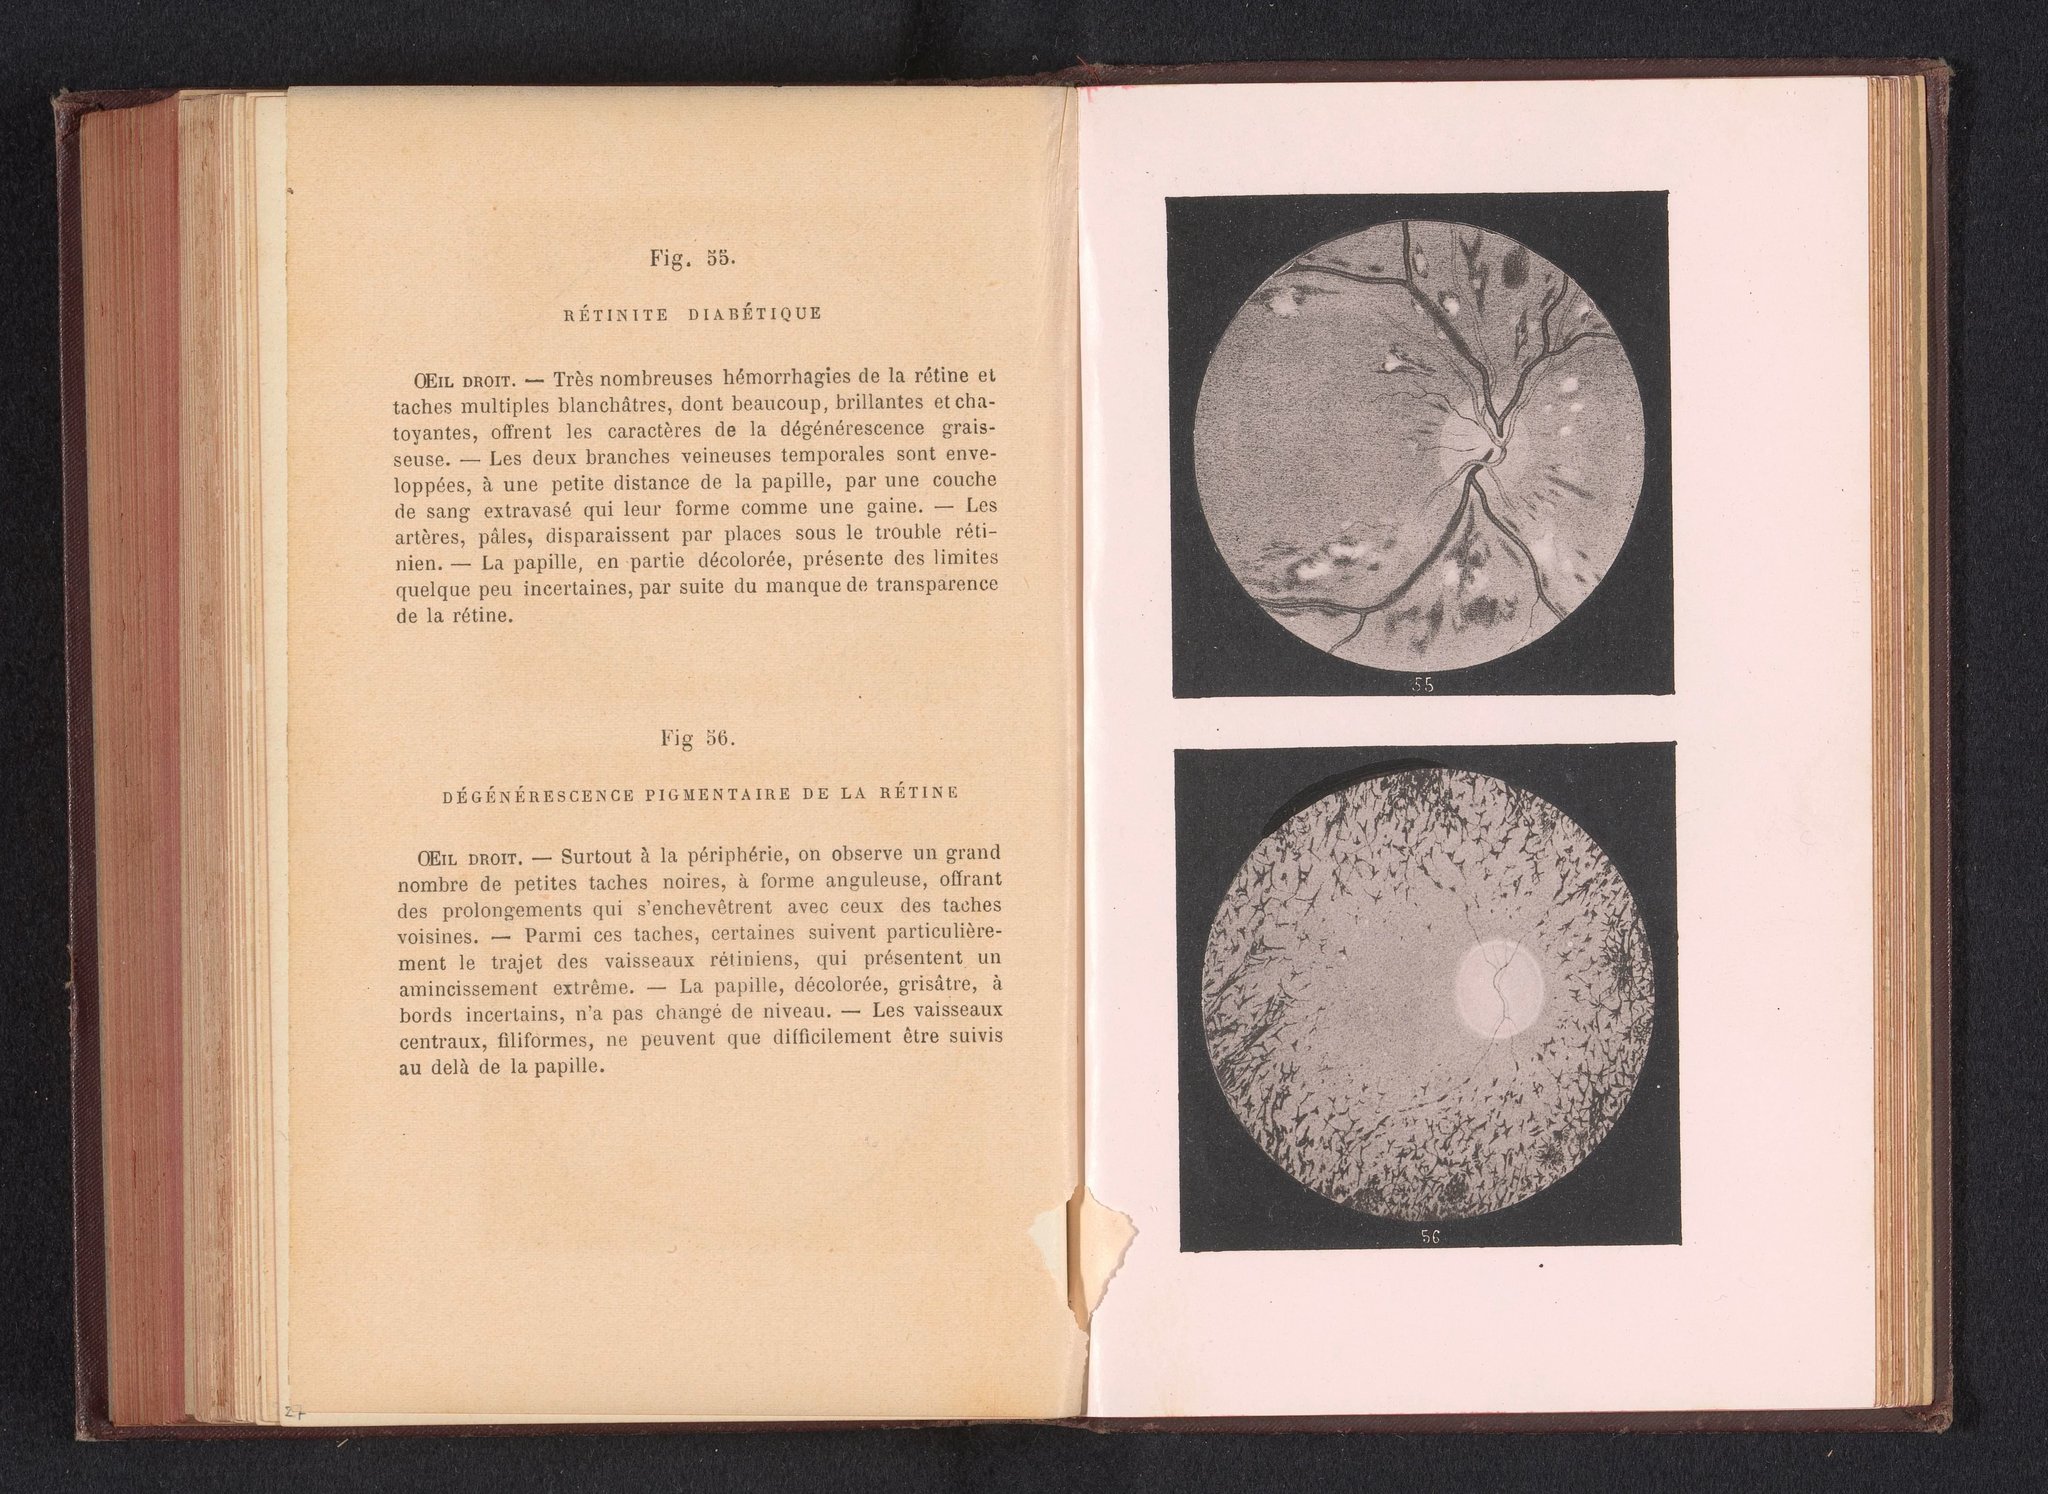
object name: page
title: Fotoreproductie van twee anatomische tekeningen van aandoeningen aan het netvlies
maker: Anonymous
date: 1871-1891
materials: paper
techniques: photograph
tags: anatomy (non-medical), eyes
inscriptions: inscription: ‘Fig. 55. Rétinite diabétique Fig. 56. Dégénérescence pigmentaire de la rétine’